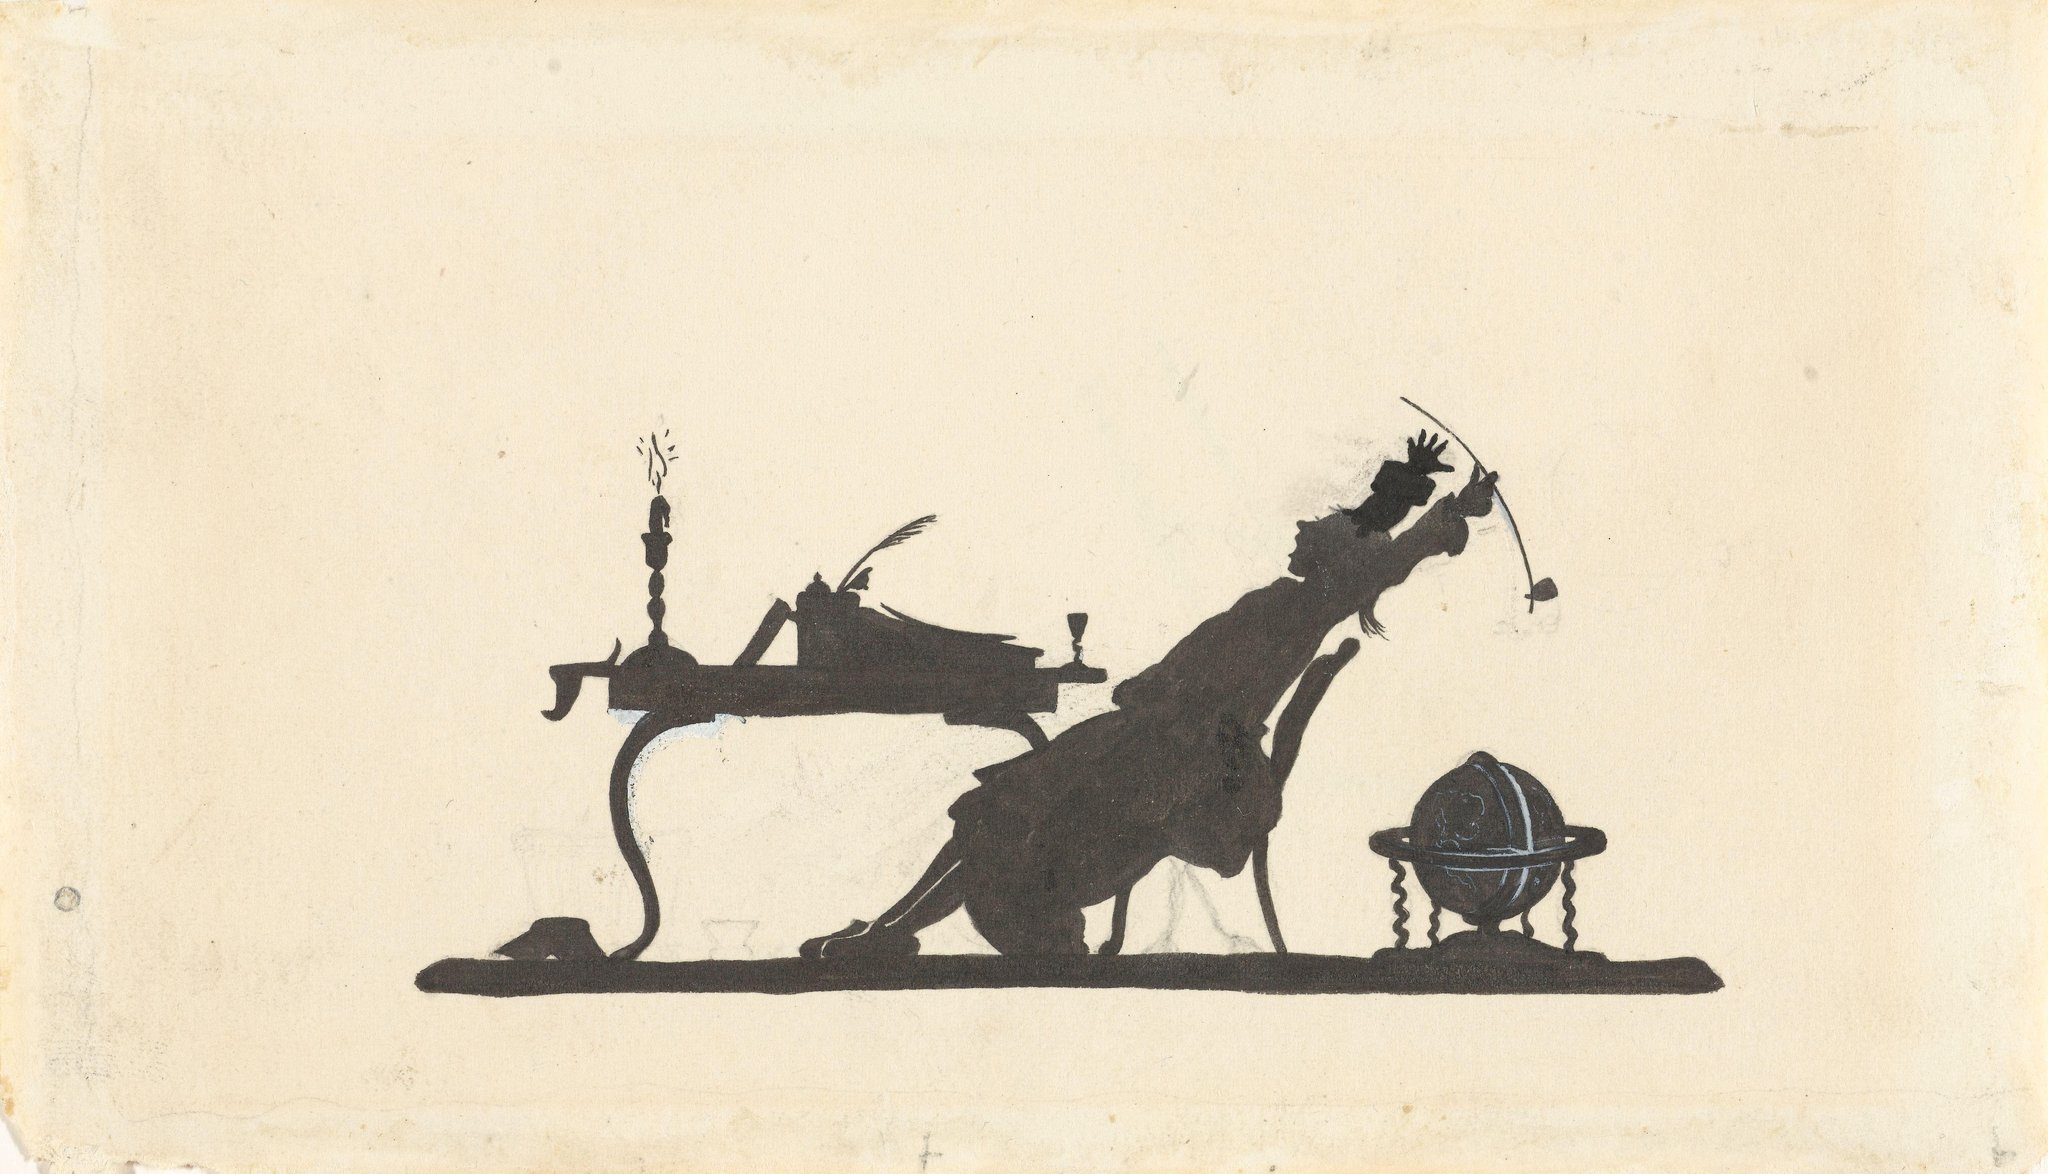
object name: design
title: Ontwerp voor In Holland staat een Huis: silhouet van een man achter zijn bureau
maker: nelly bodenheim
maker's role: designer, draughtsman, print maker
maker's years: 1874-1951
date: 1884-1917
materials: paint, paper, pencil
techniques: brush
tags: 83(van looy, in holland staat een huis)